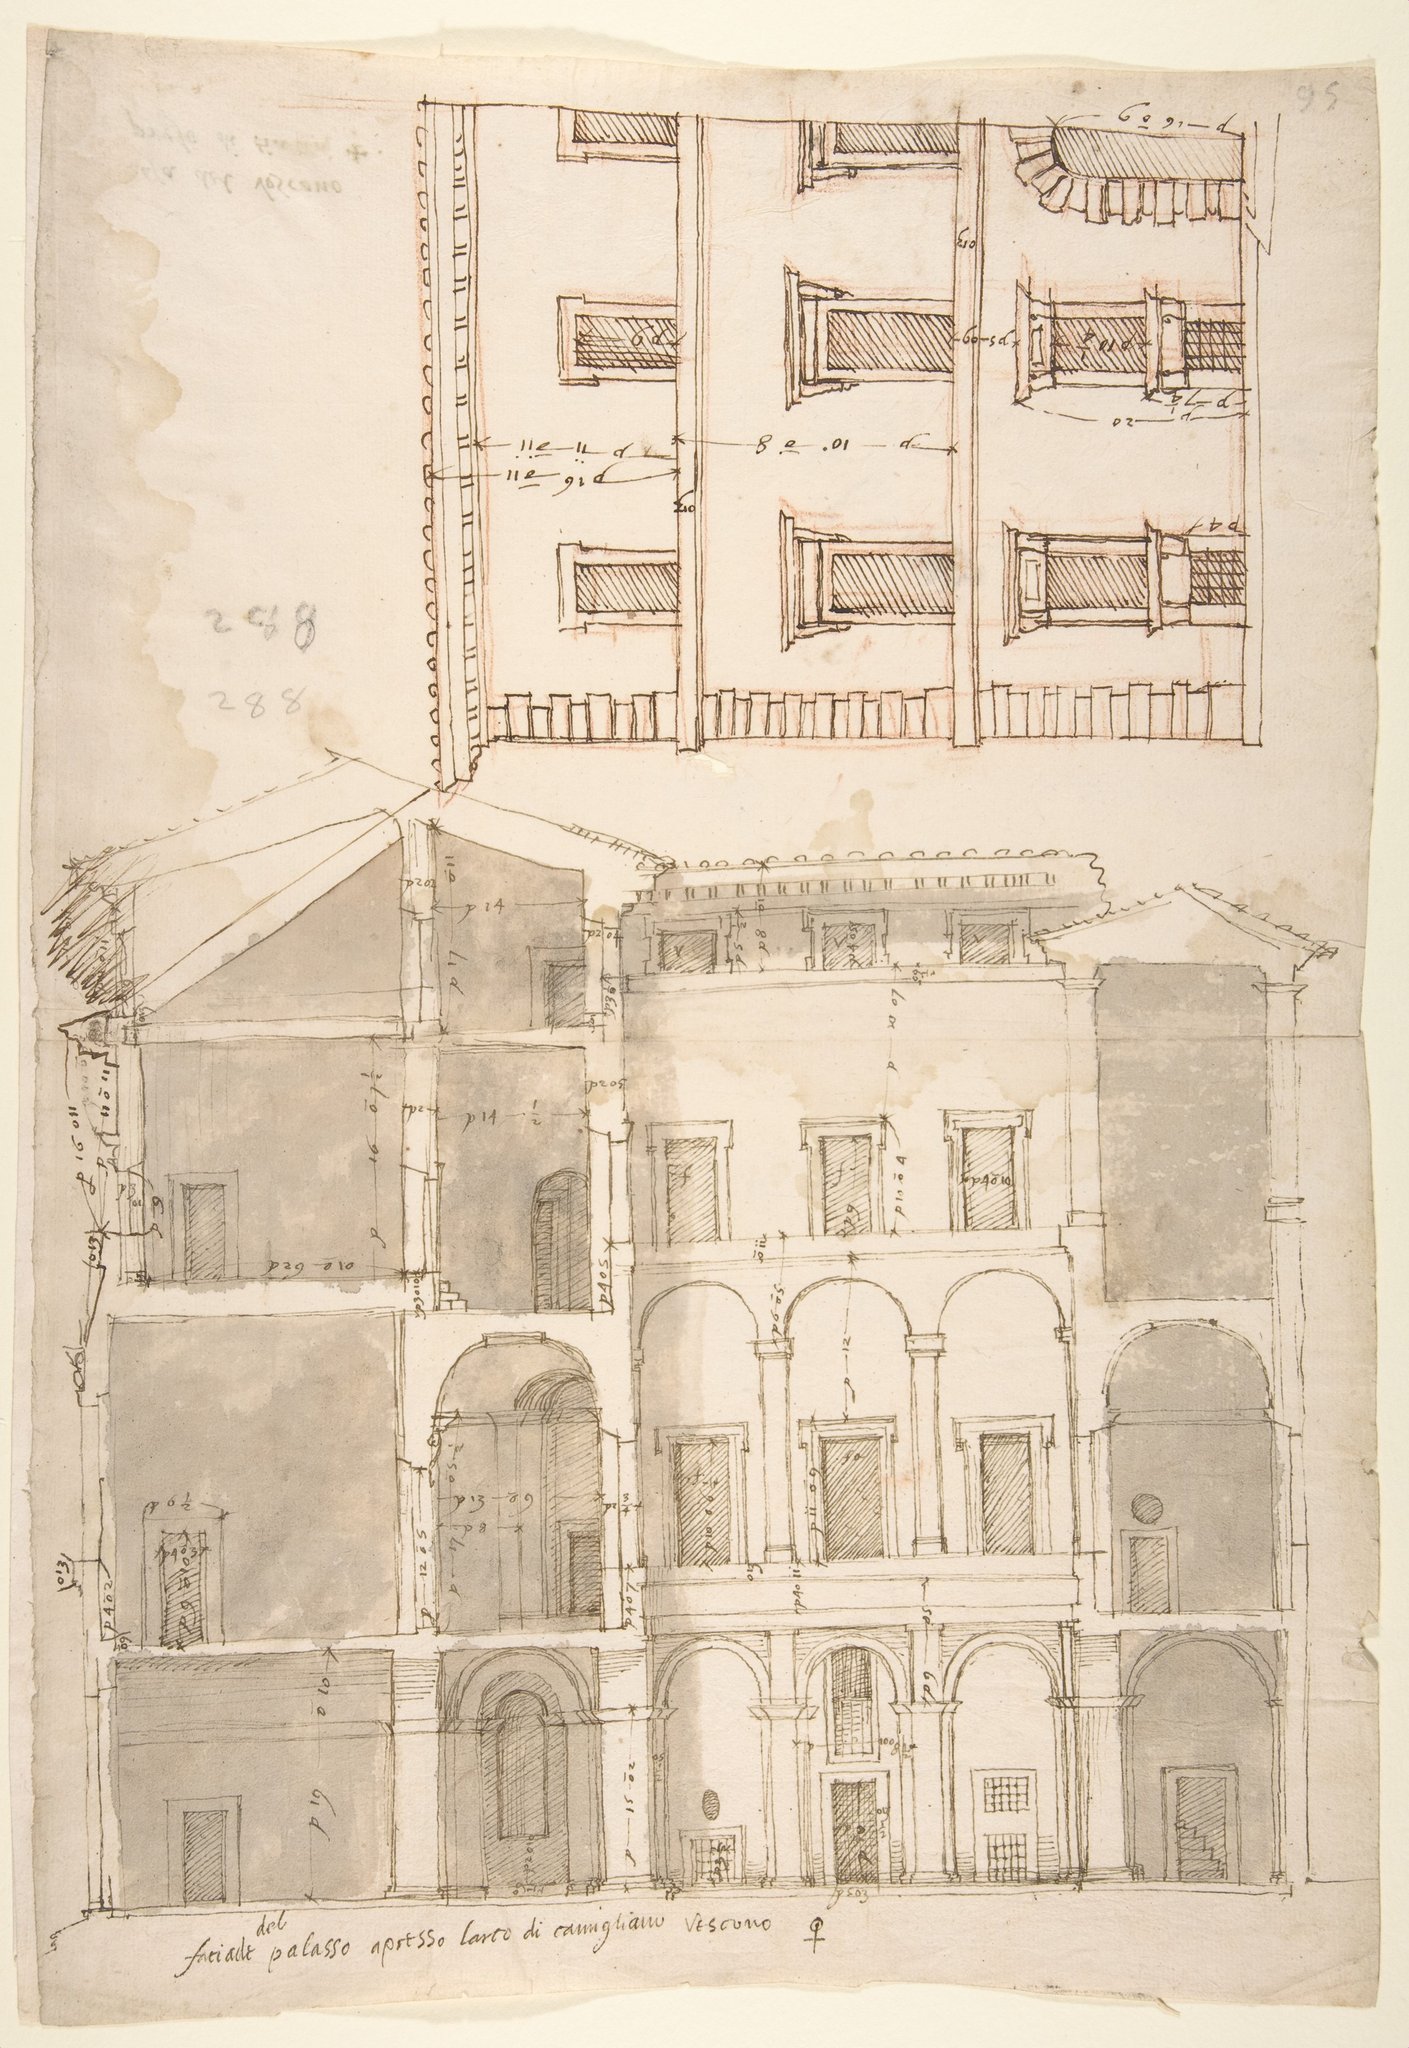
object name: drawing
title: Unidentified Palace, section and half elevation (recto) blank (verso)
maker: anonymous, french, 16th century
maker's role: draftsman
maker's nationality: french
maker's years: 1500-1600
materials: chalk, ink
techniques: incising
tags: architecture,palaces